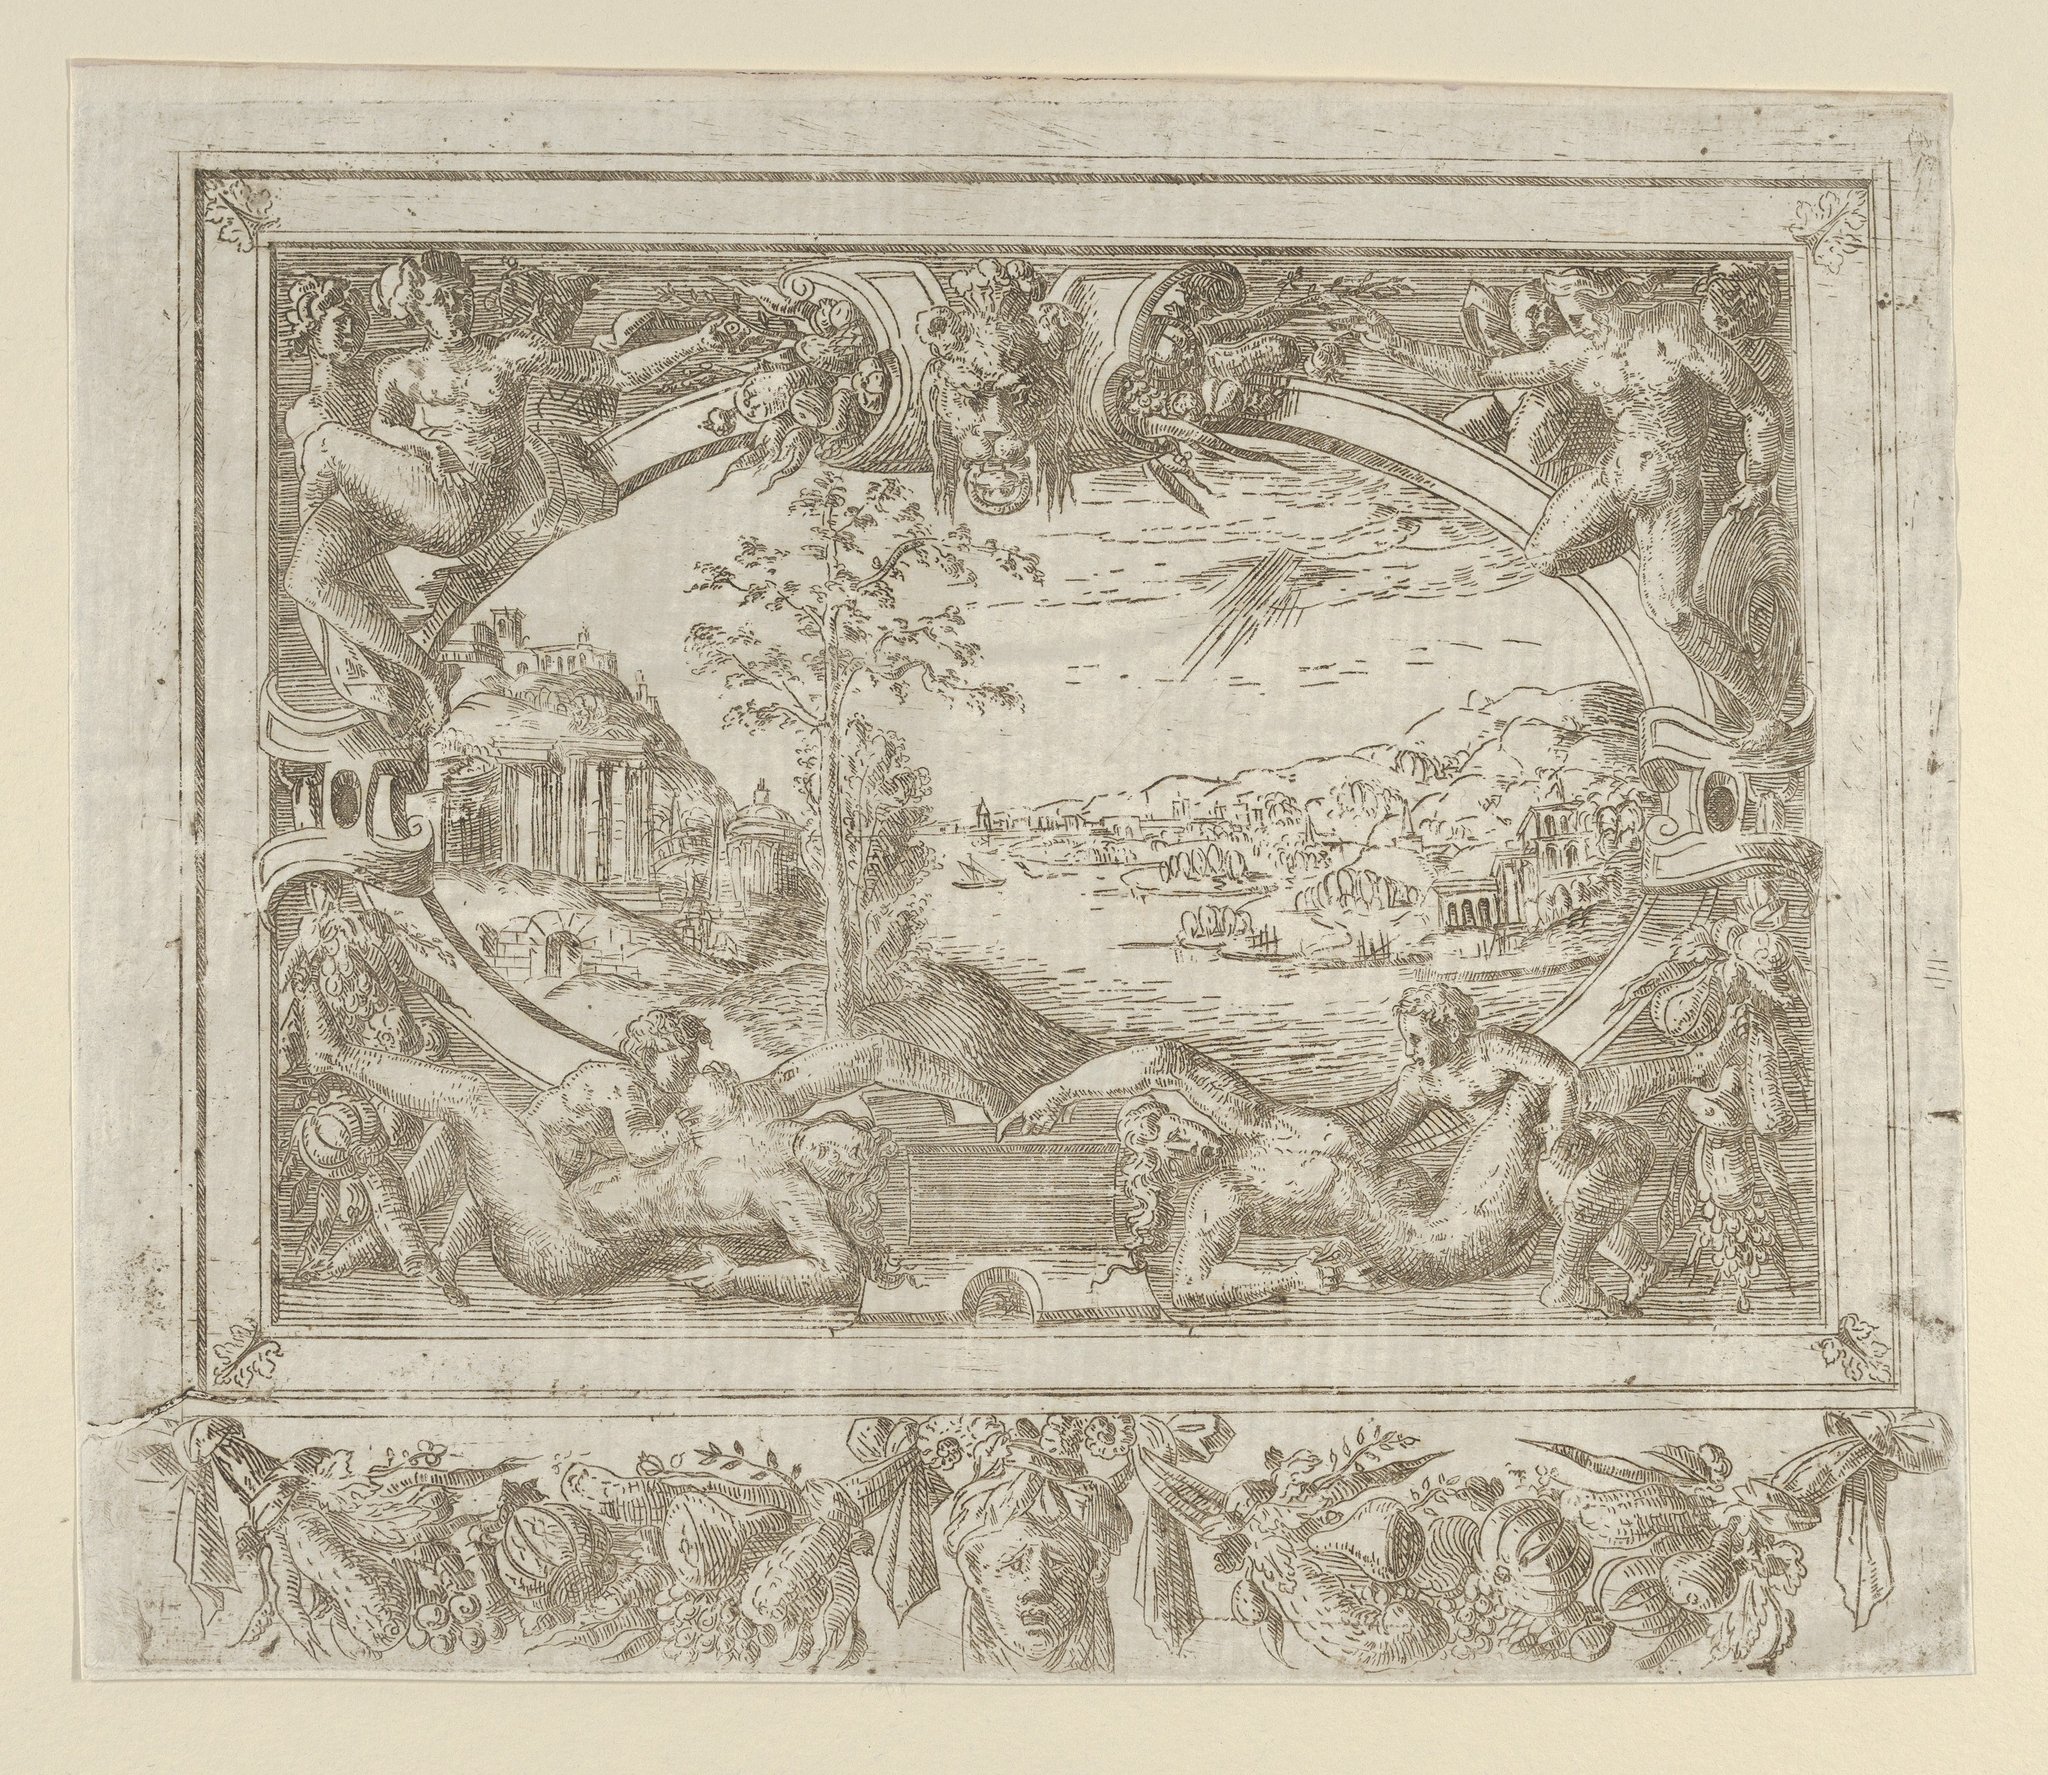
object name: print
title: Landscape in a Frame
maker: anonymous, french, school of fontainebleau, 16th century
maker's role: artist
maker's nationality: french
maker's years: 1500-1600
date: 1542-1545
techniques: etching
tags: male nudes,female nudes,landscapes